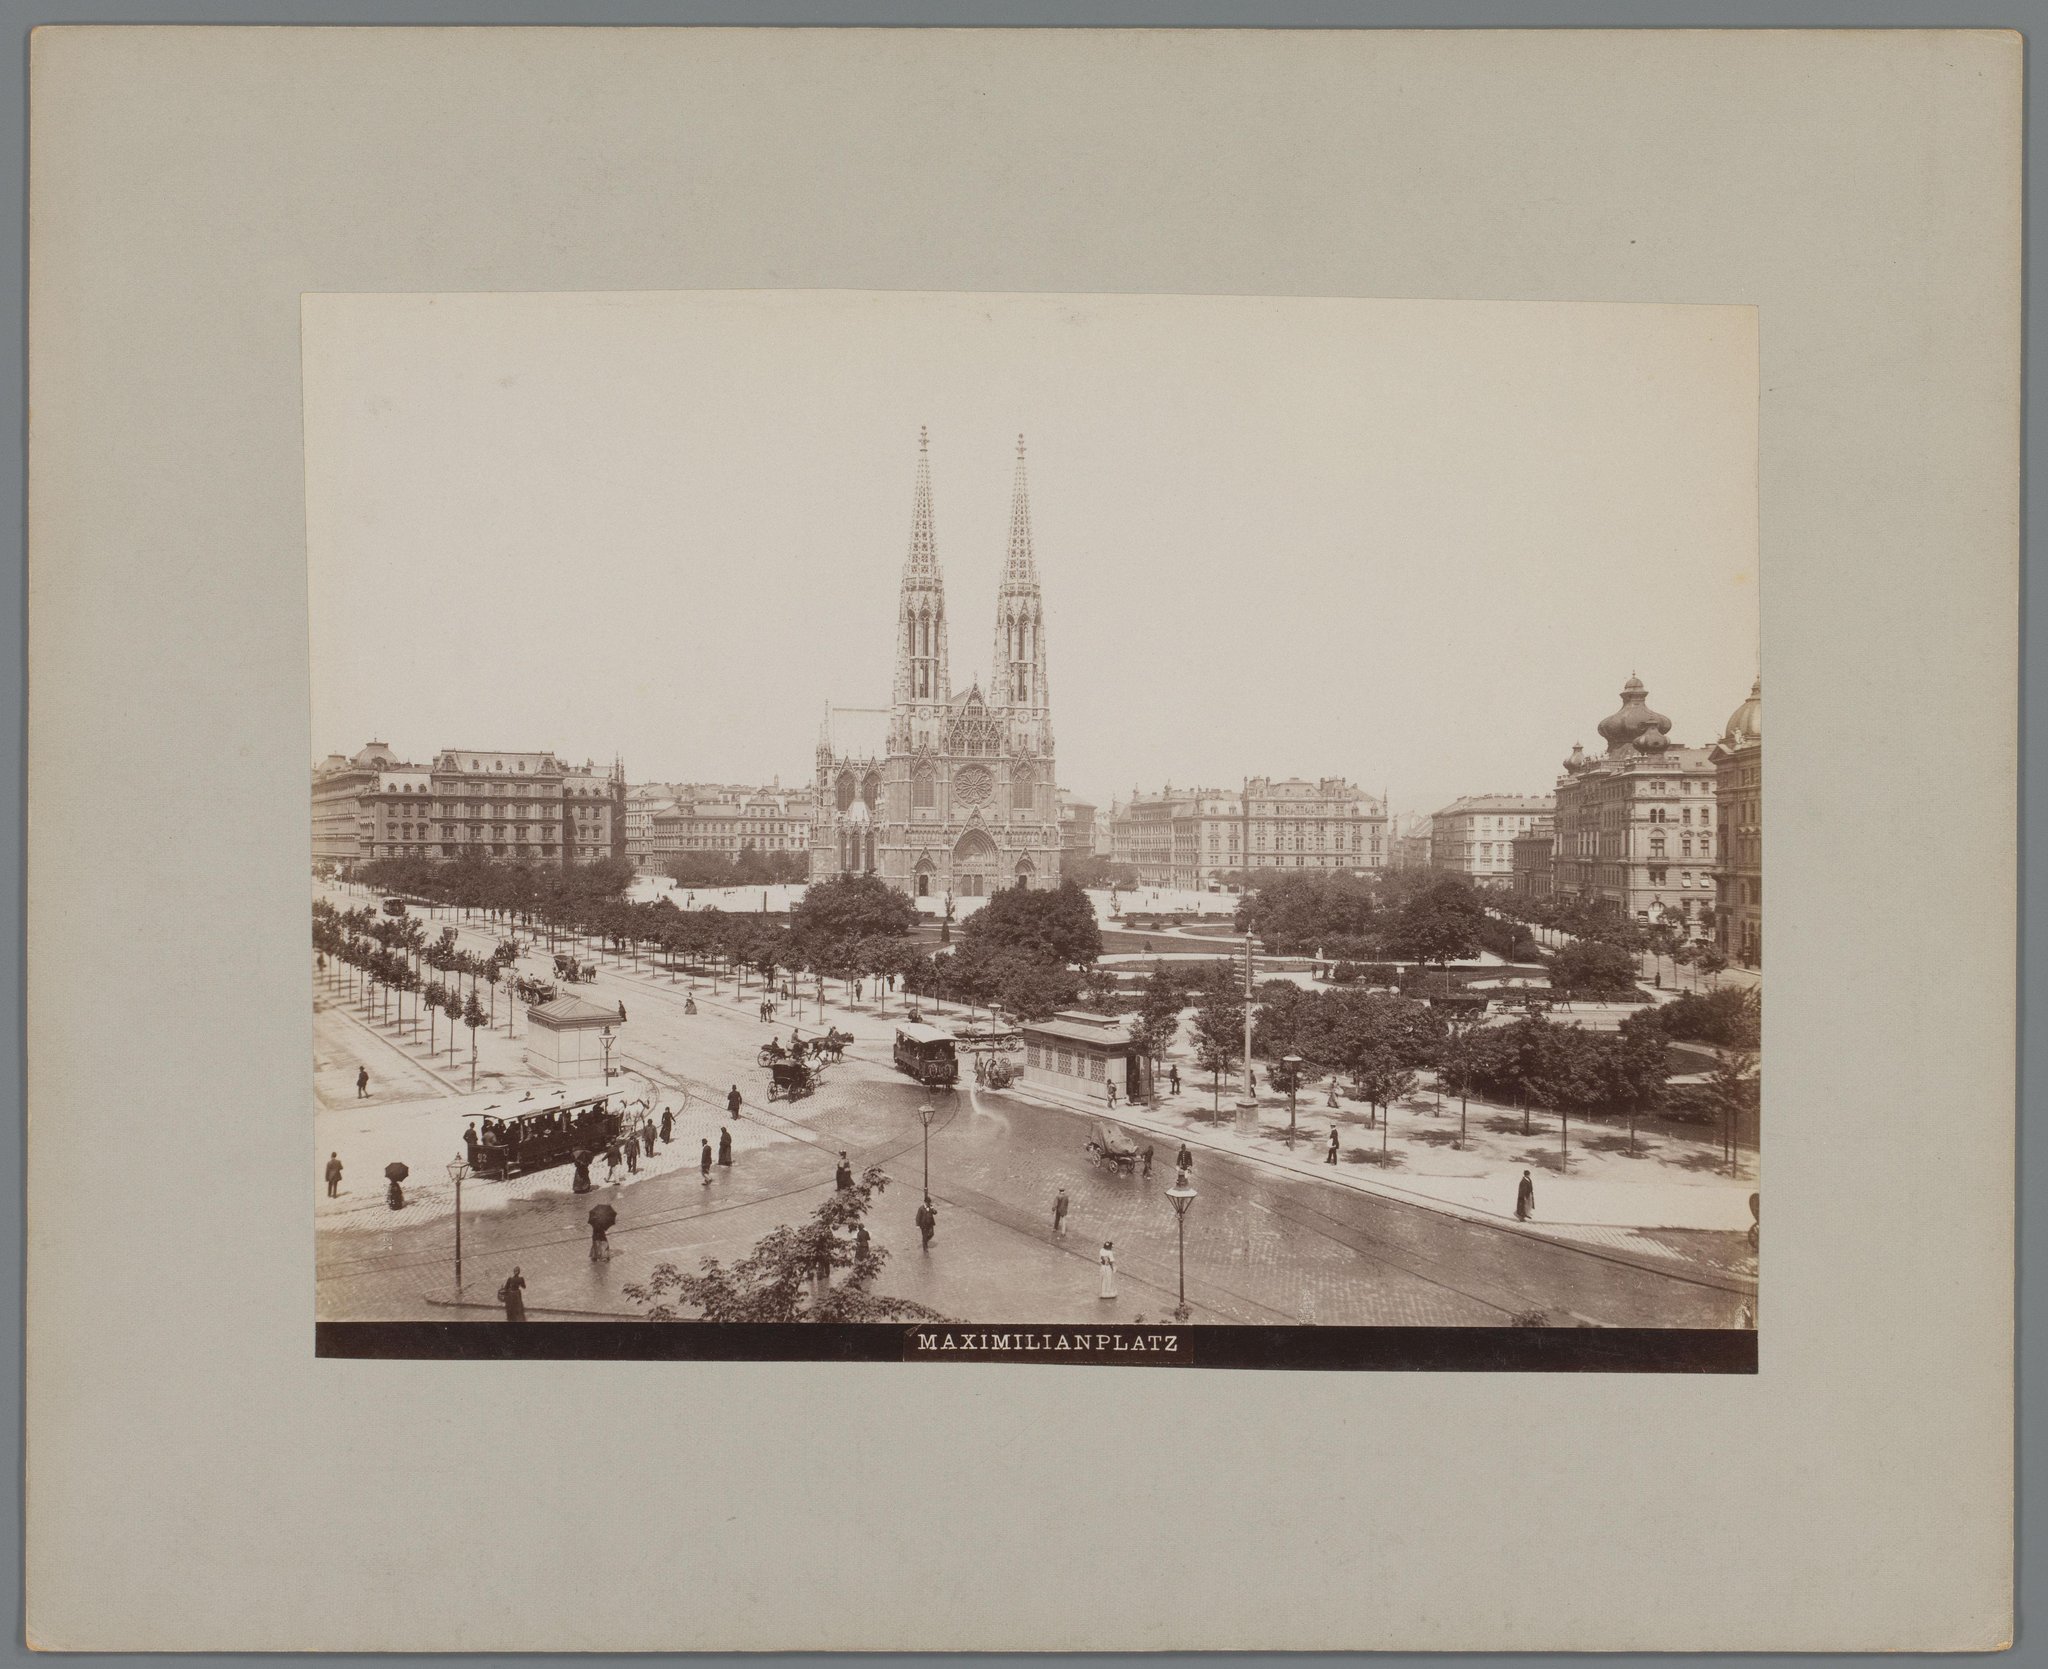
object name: photograph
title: Gezicht op de Maximiliansplatz, Wenen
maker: Anonymous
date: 1879-1897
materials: cardboard, paper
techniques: albumen print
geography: vienna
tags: square, place, circus, etc., diligence, omnibus, horse-tram, church (exterior)